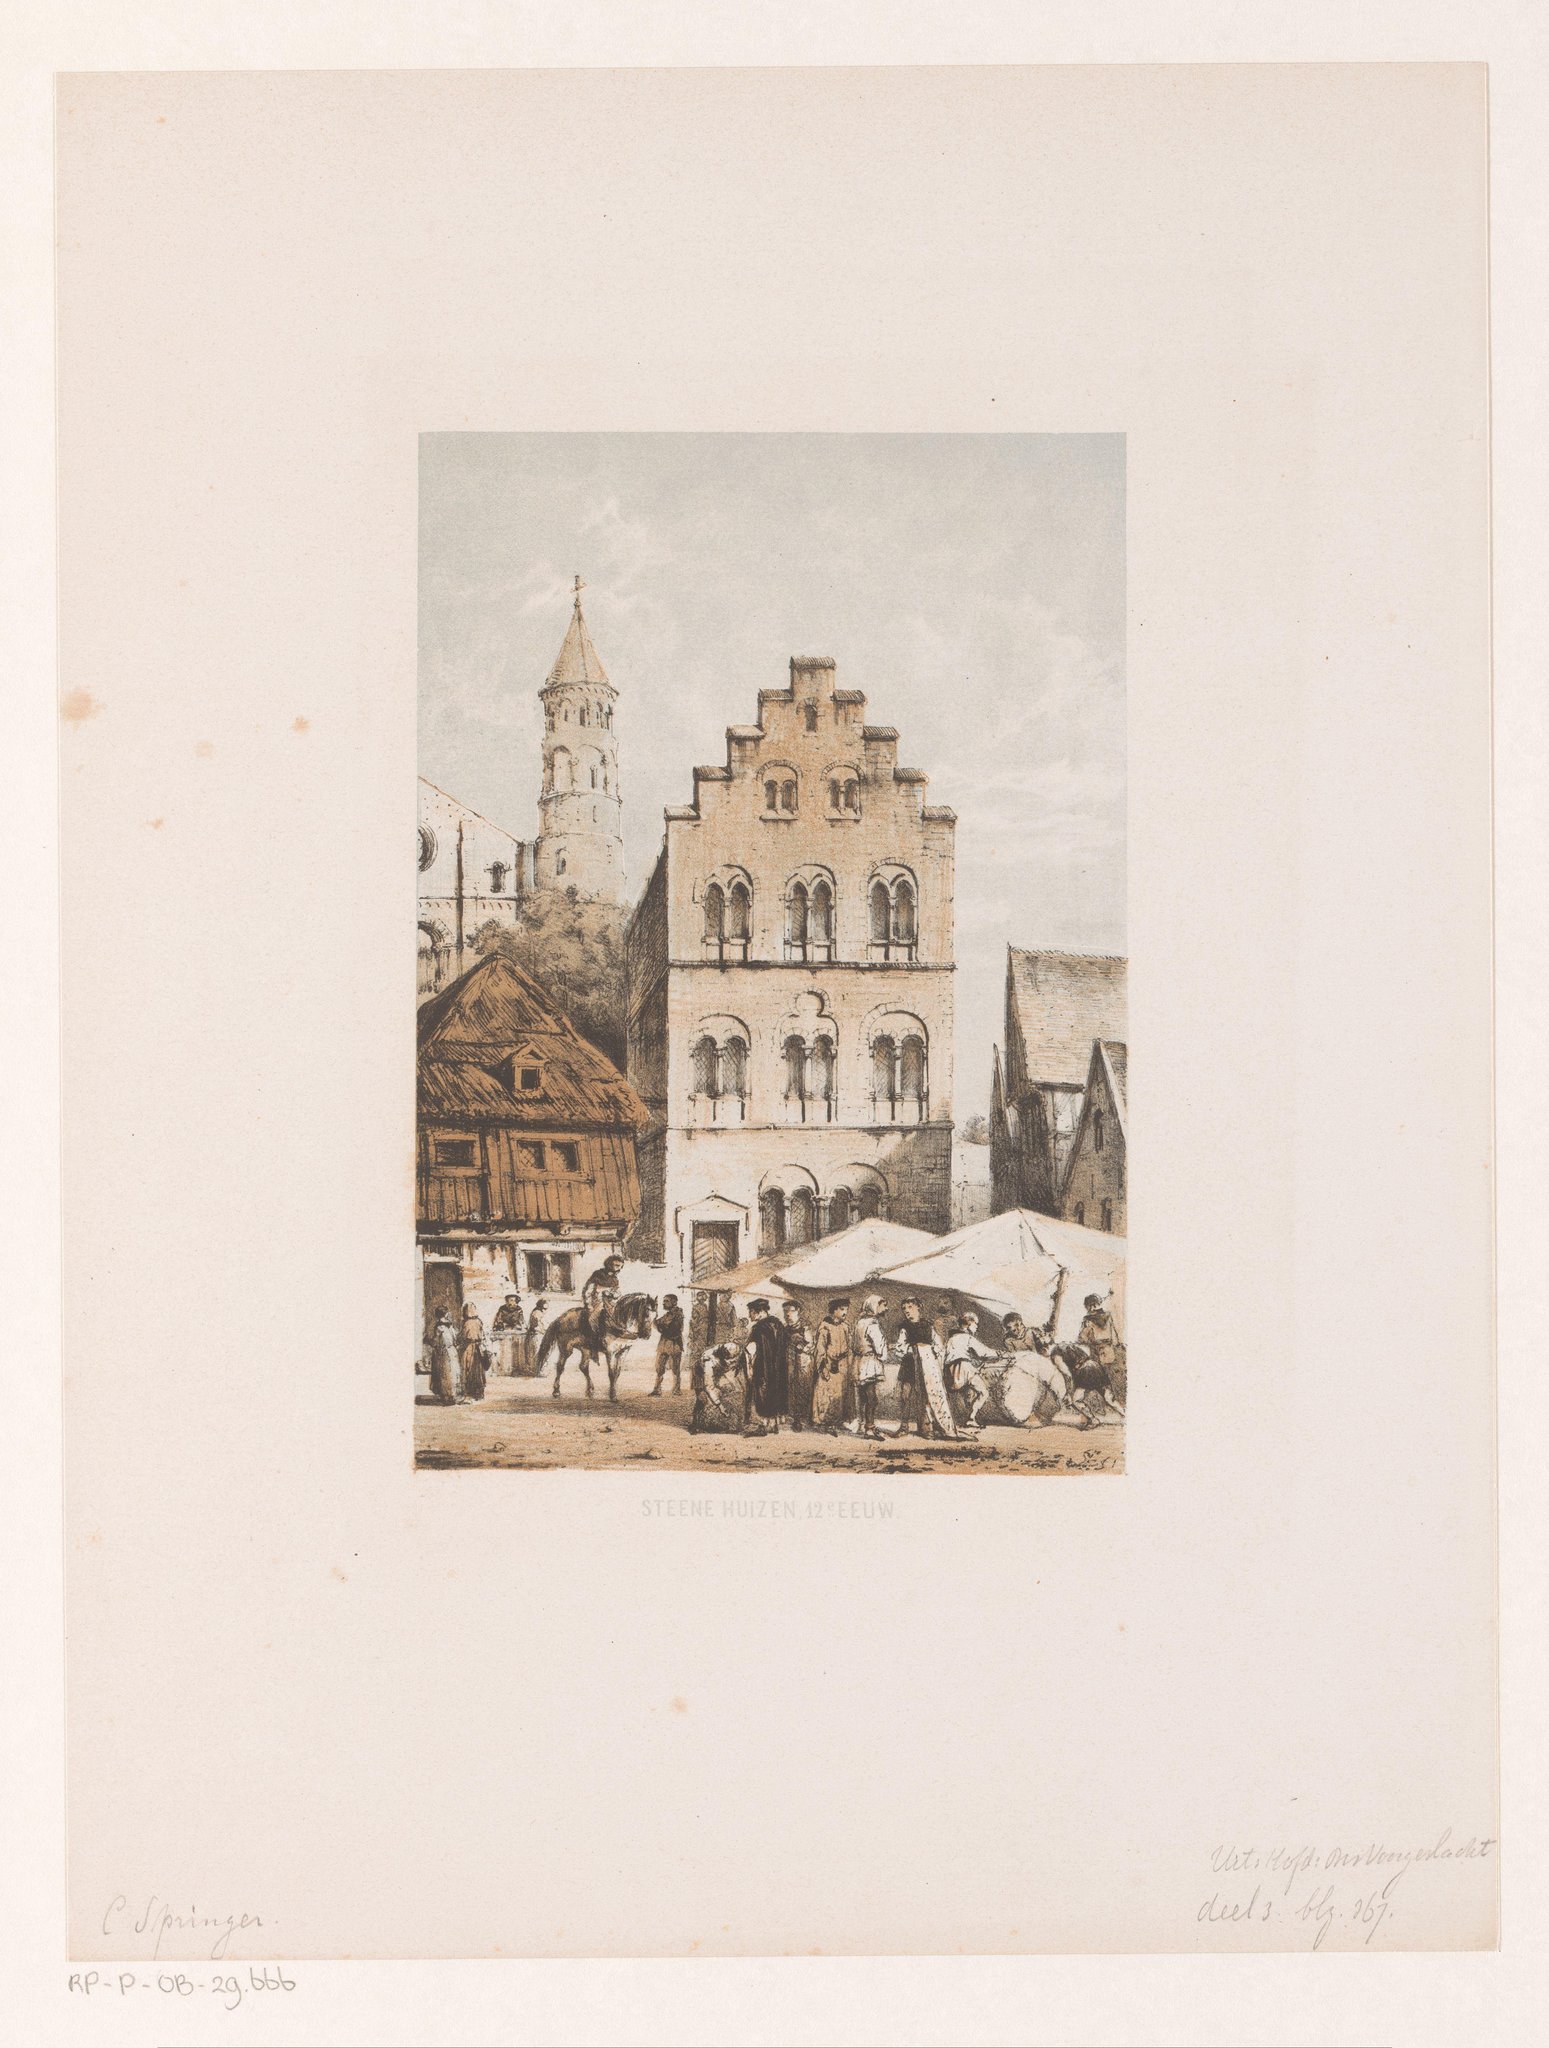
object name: book illustration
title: Steene huizen 12e eeuw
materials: paper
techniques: tone lithography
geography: netherlands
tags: housing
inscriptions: collector's mark: Lugt 2228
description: Prent uit: Hofdijk, W.J. Ons voorgeslacht. Haarlem: Kruseman, Arie Cornelis, 1861.